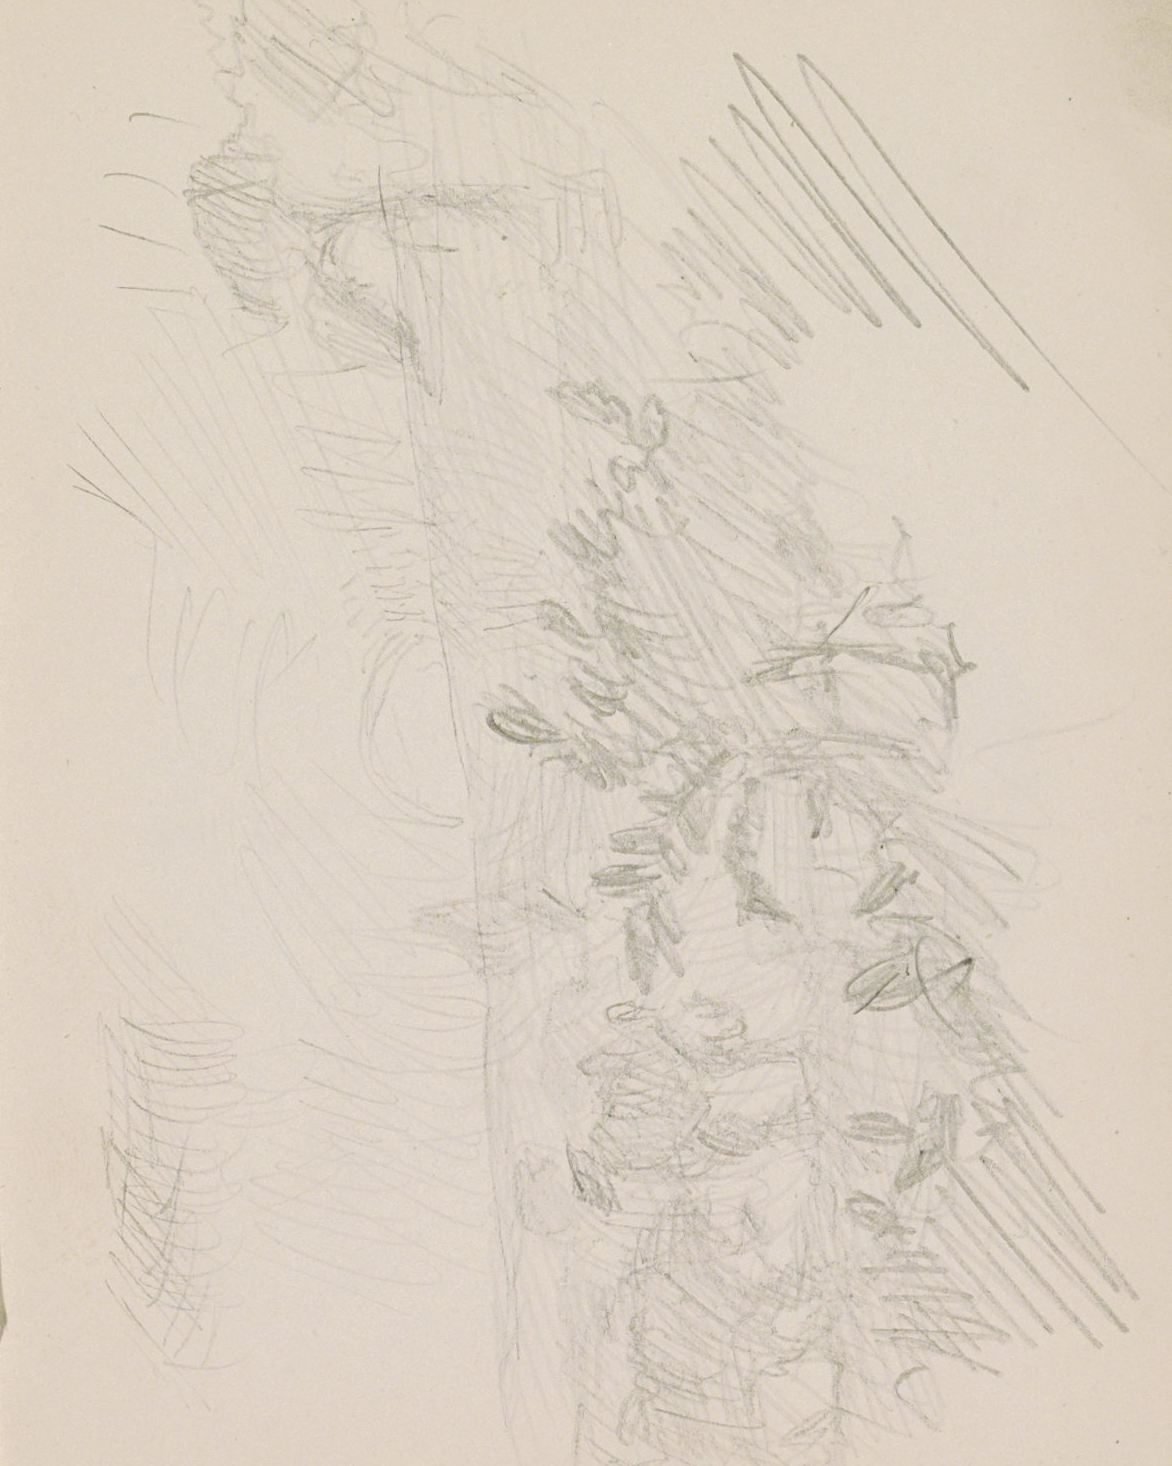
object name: sketchbook leaf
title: Landschap met struiken en een boom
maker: reijer stolk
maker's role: draughtsman, print maker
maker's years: 1896-1945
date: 1916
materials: paper, pencil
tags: landscapes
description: Blad 28 recto uit een schetsboek met 72 bladen.